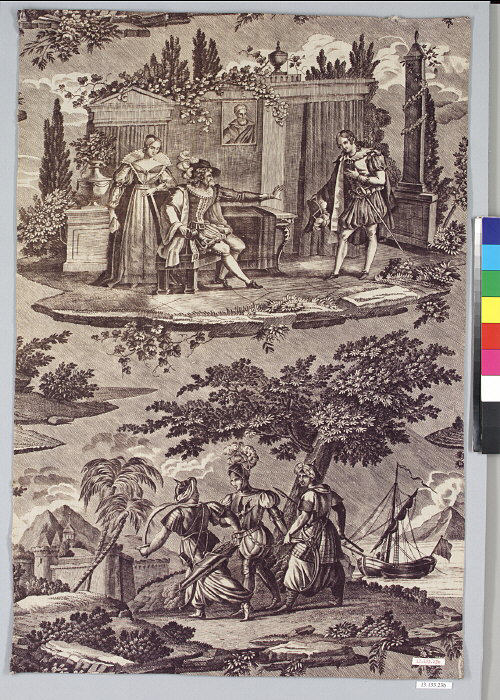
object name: piece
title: Scenes from a romance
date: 1815-1825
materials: cotton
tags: men,women,boats